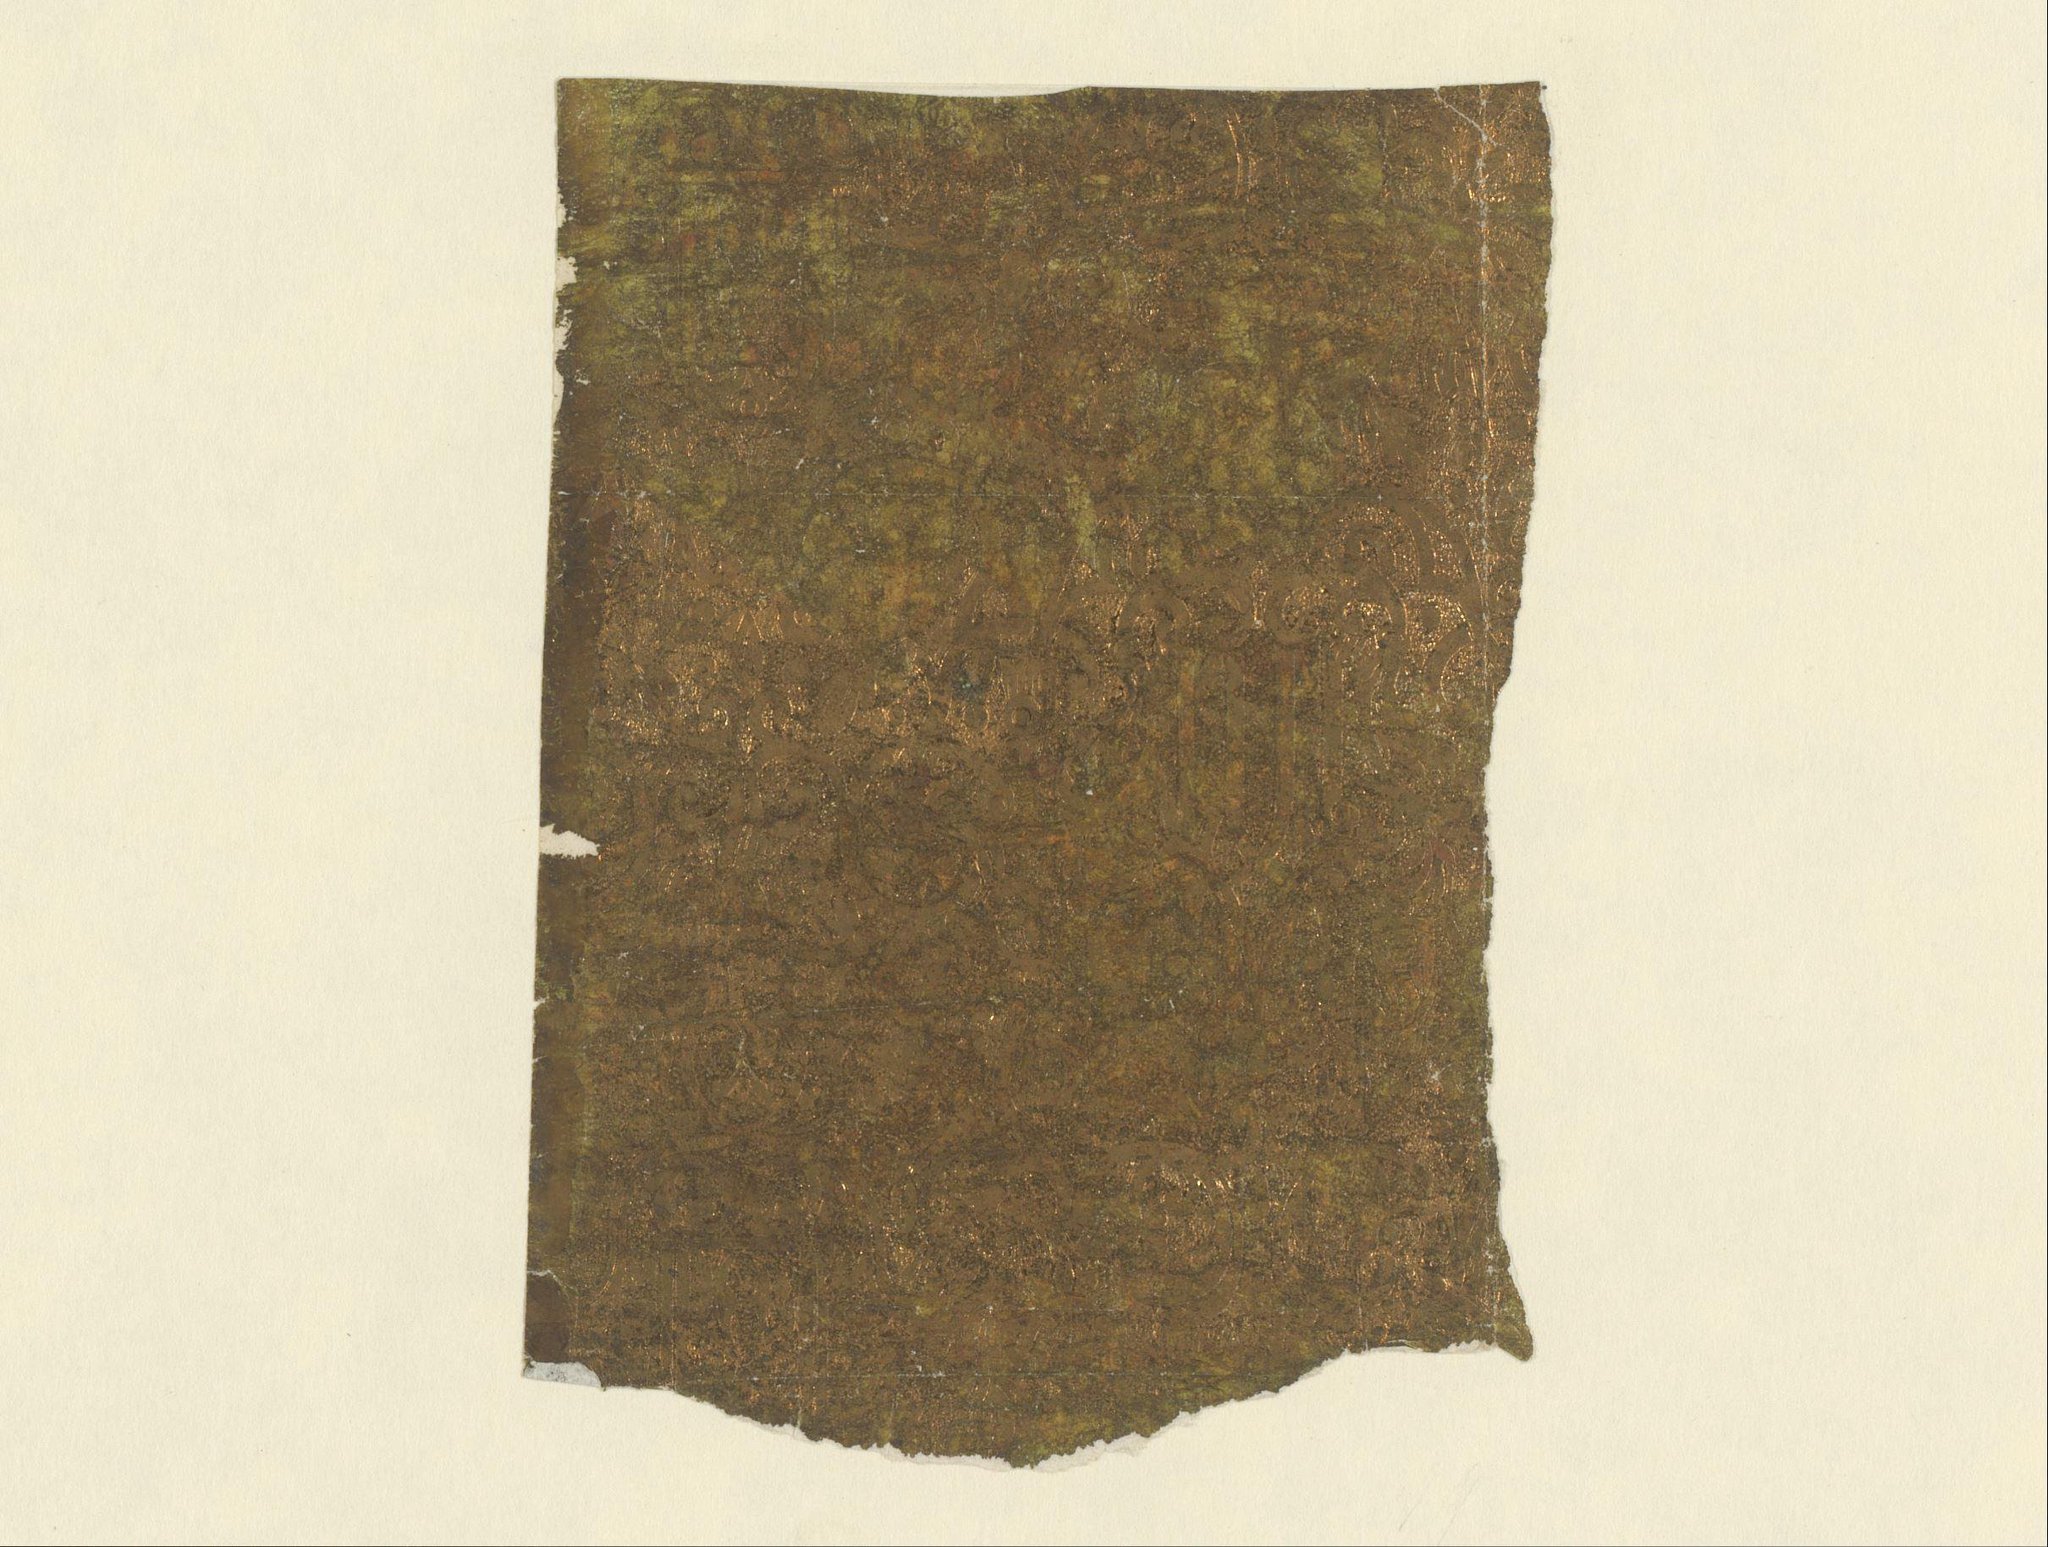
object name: brocade paper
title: Blad met onduidelijk patroon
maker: Anonymous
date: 1700-1820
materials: gold leaf, paint, paper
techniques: relief print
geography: germany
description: Fragment van een blad met een moeilijk leesbaar patroon.